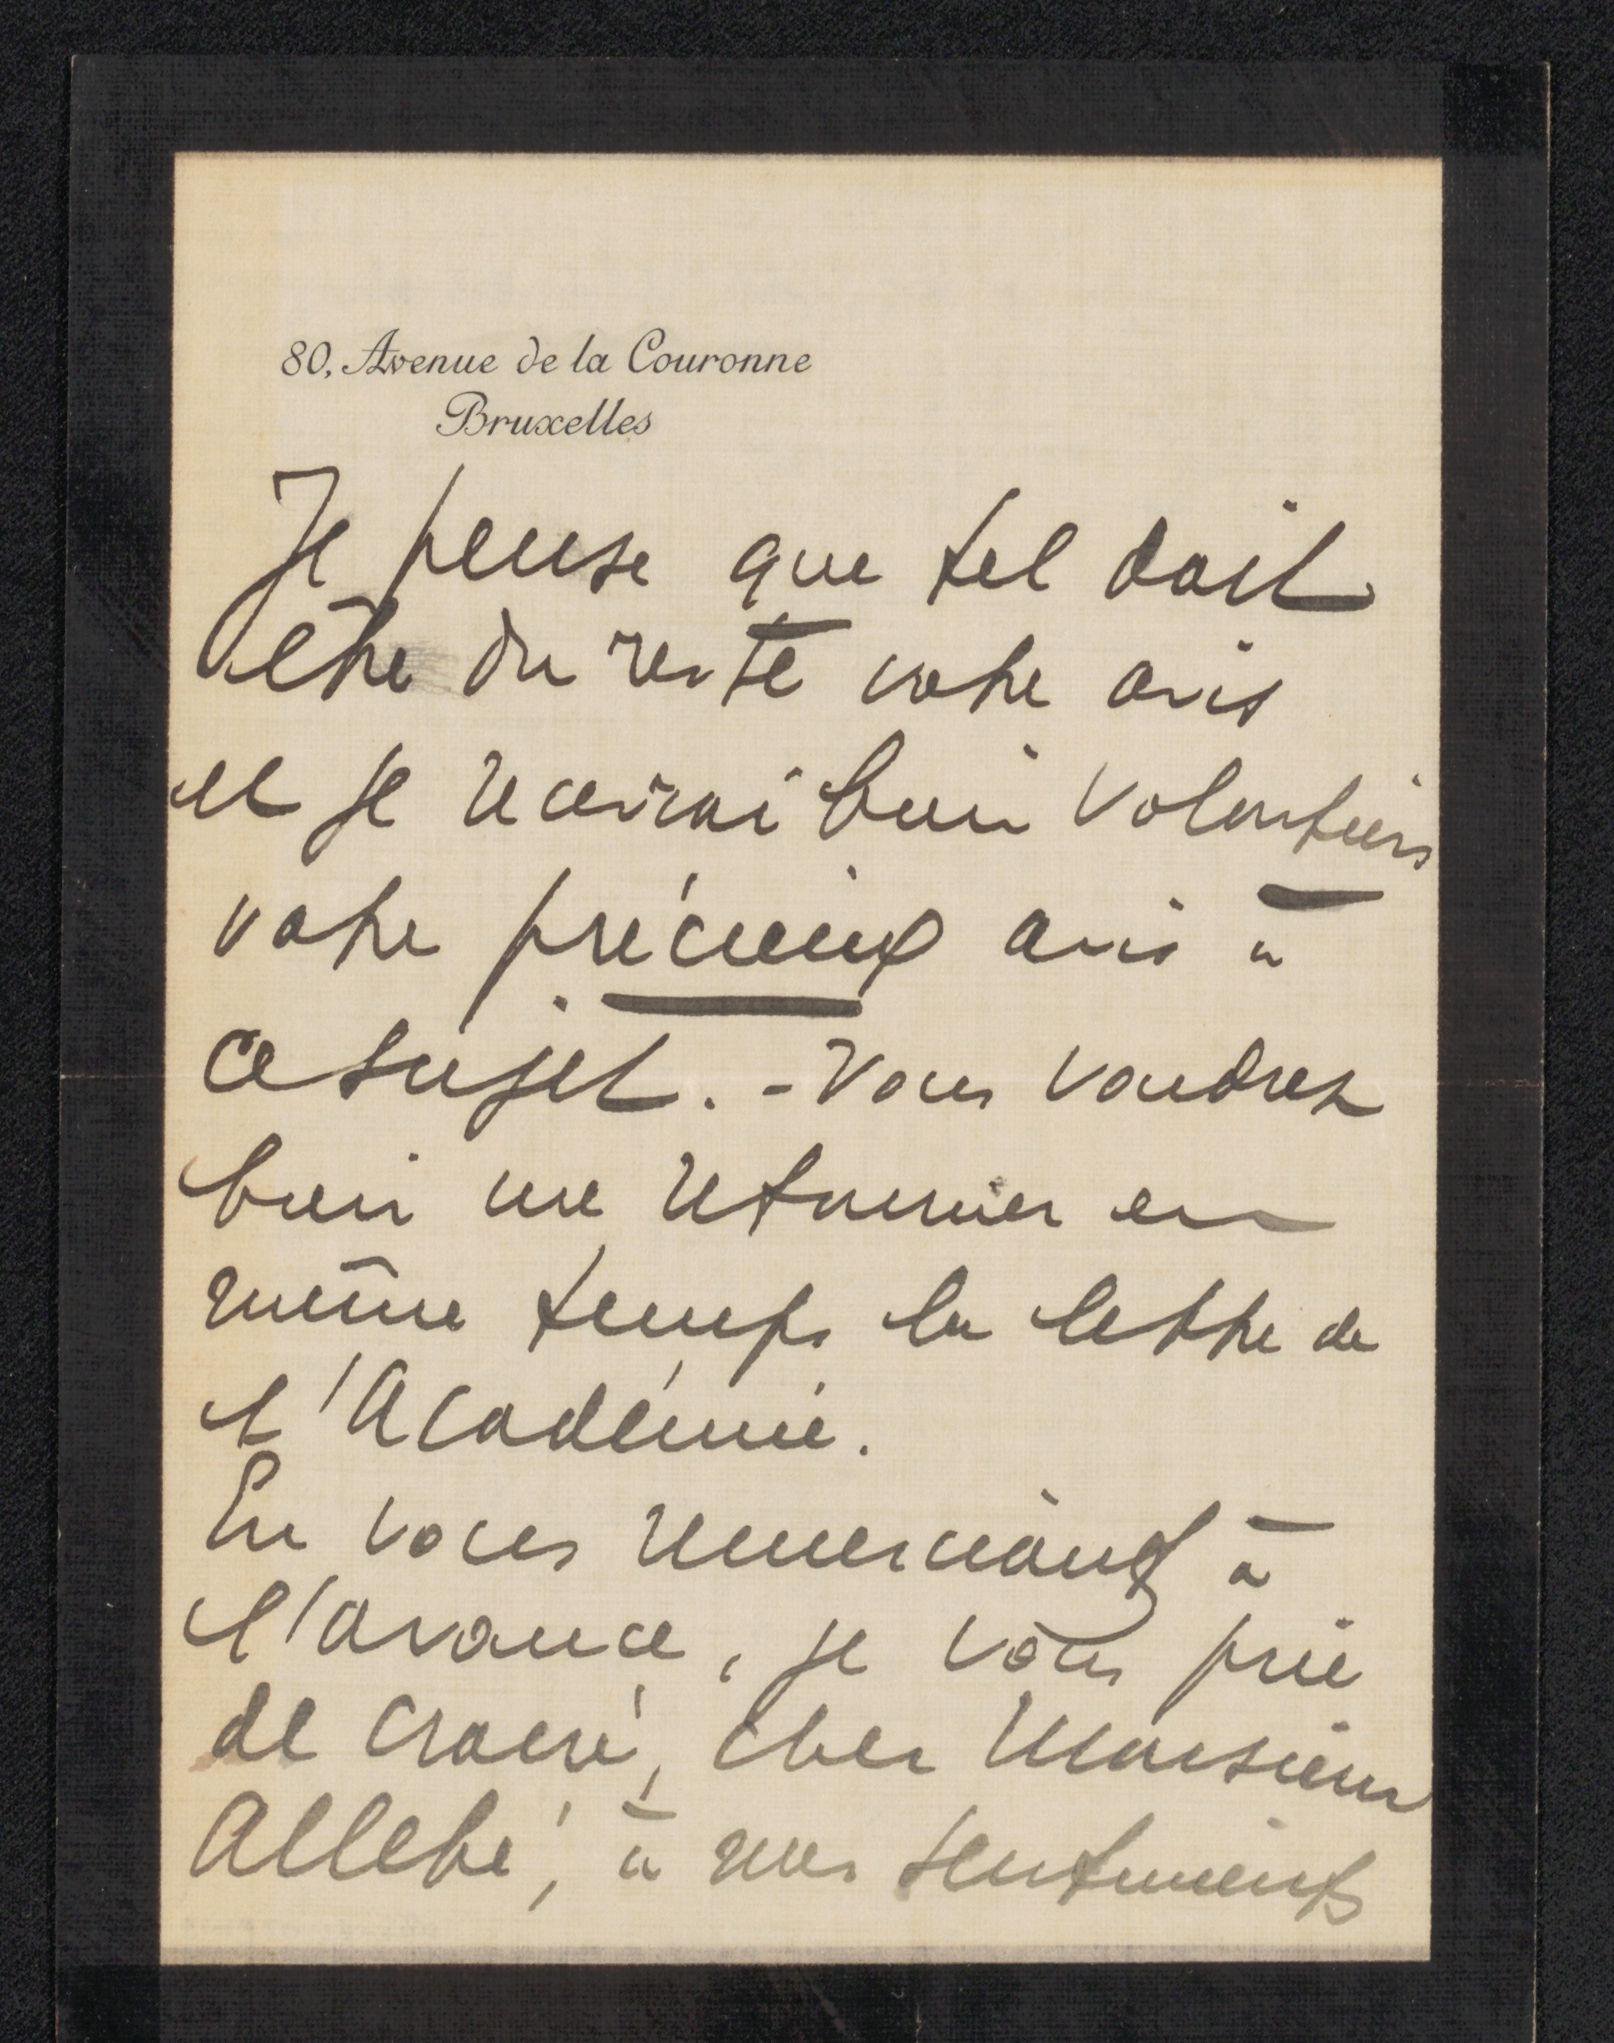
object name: letter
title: Brief aan August Allebé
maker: e. de haas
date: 1848-1927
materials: ink, paper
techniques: pen, printing, writing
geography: brussels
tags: amsterdam, draughtsman, august allebé